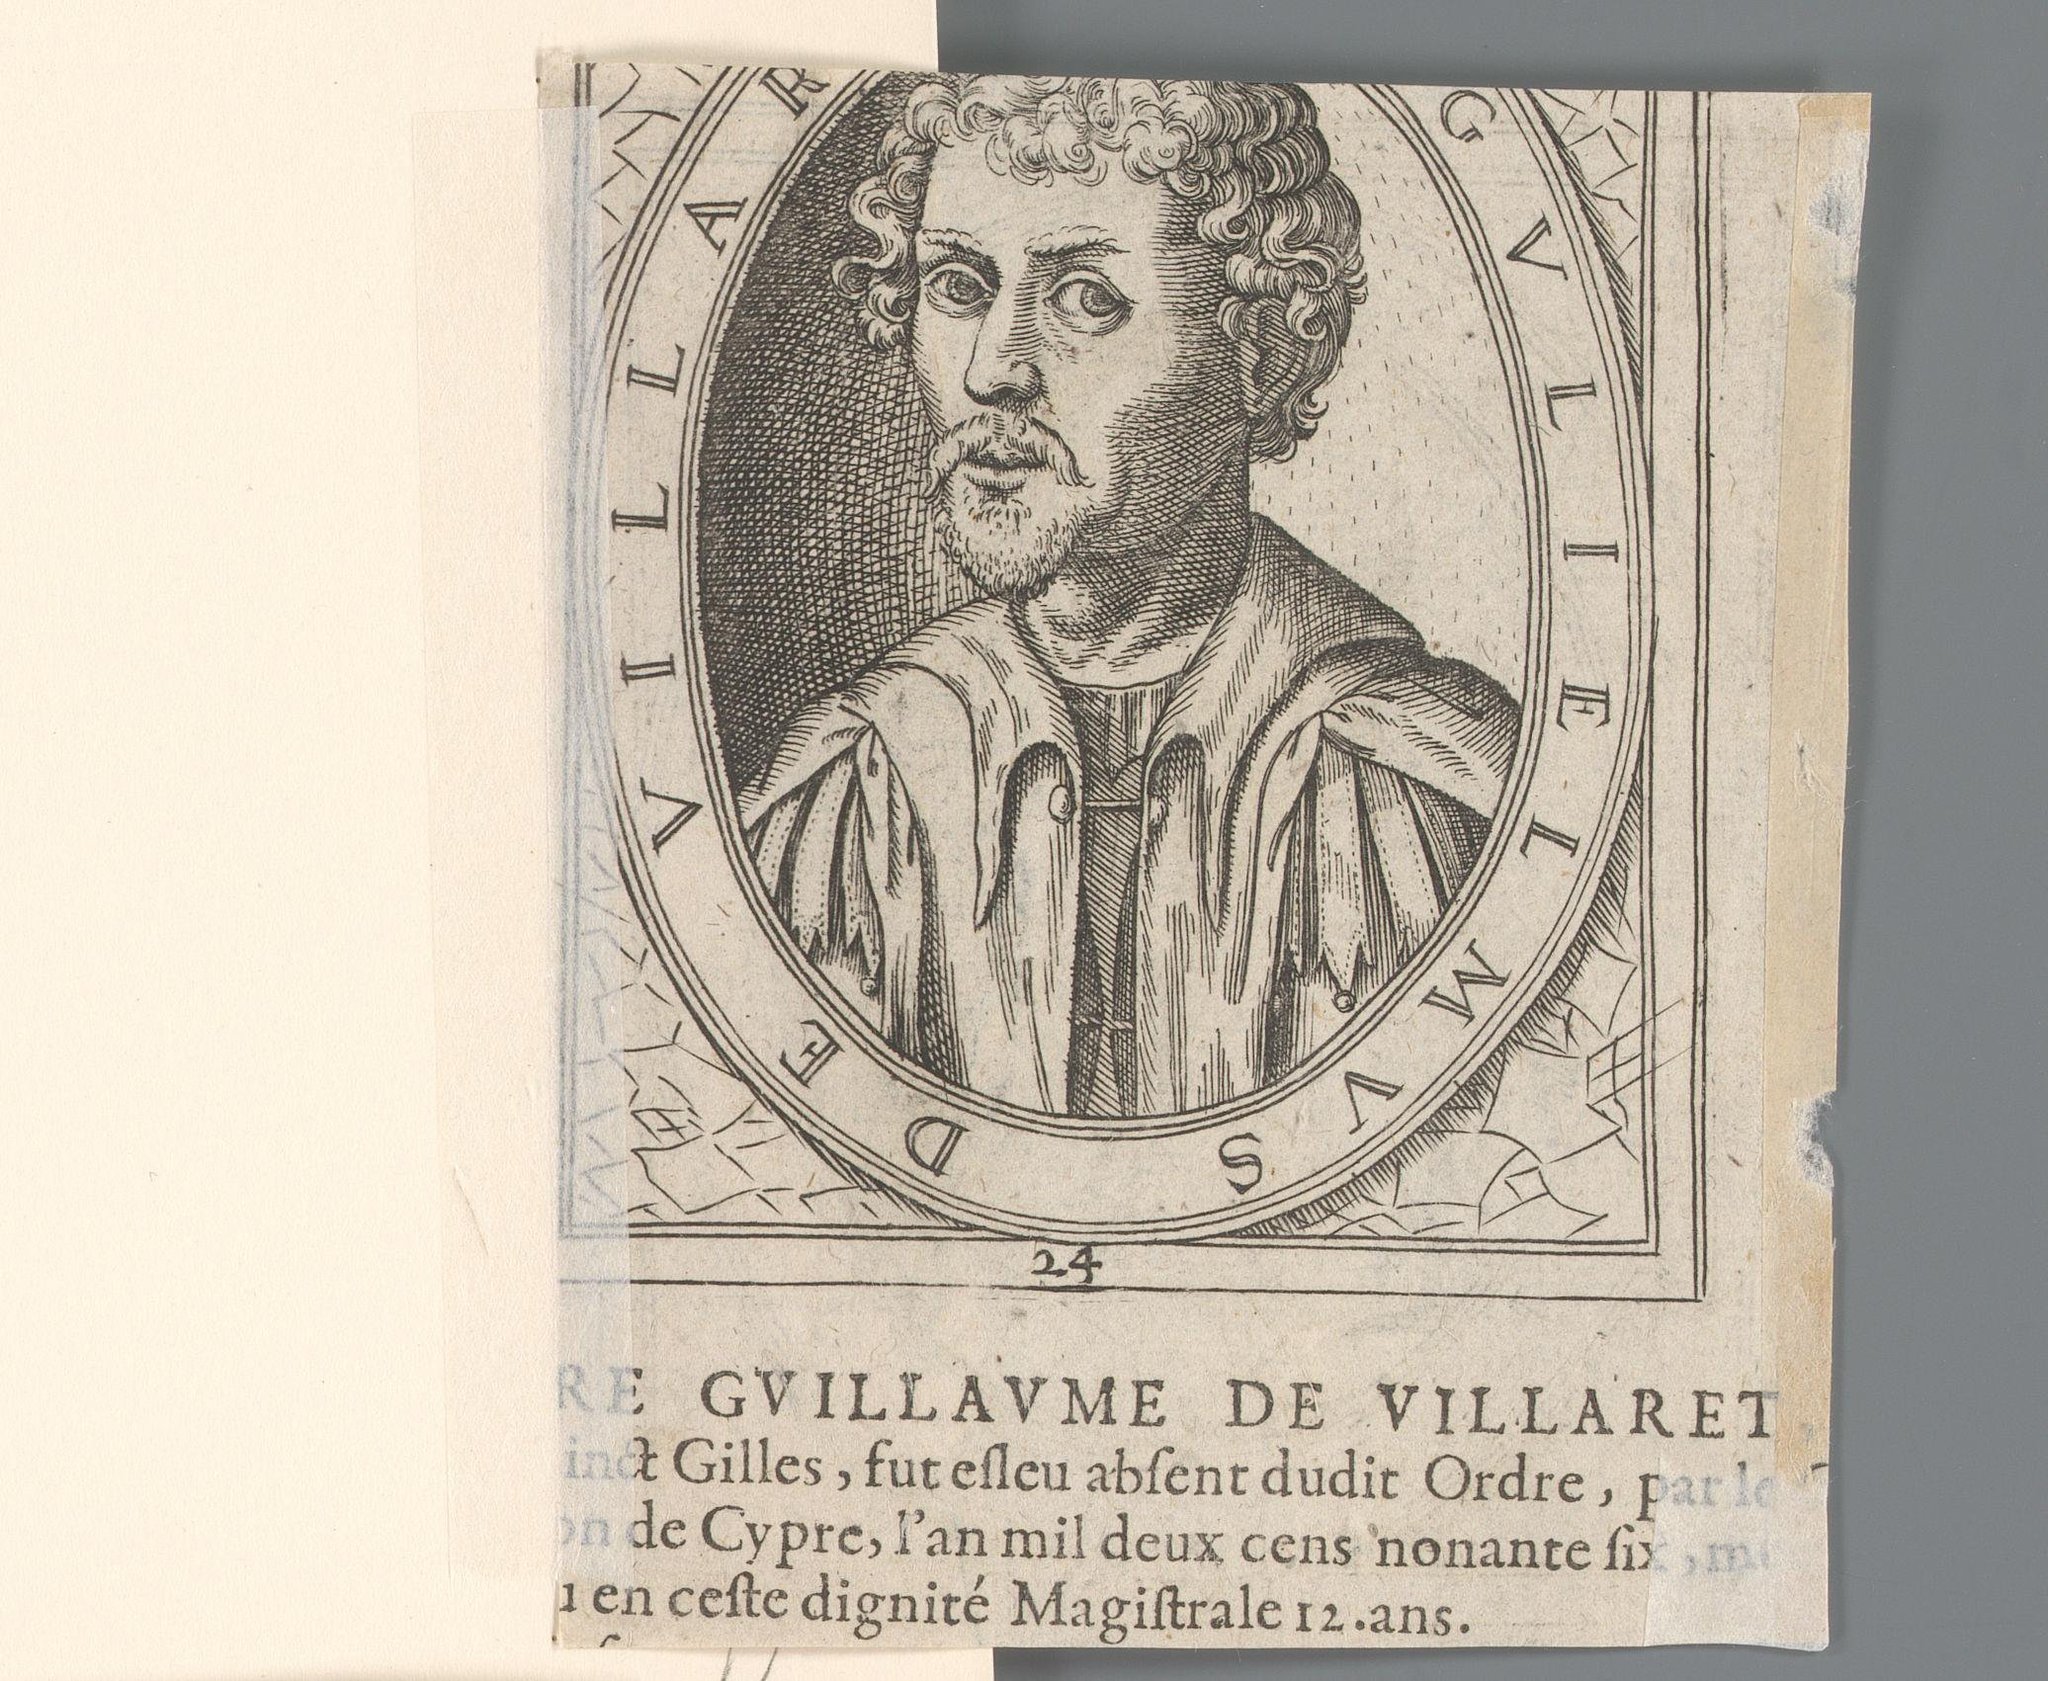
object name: print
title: Portret van Guillaume de Villaret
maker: Anonymous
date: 1643-1659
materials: paper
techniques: engraving, letterpress printing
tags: historical persons, military orders, e.g.: knights templars, knights of malta, teutonic knights ~ roman catholic church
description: Prent mogelijk uit: Baudoin, Jean. Histoire des chevaliers de l'ordre de s. Jean de Hierusalem (...). Parijs: Jacques Dallin, 1643. Of uit: Baudoin, Jean. Histoire des chevaliers de l'ordre de s. Jean de Hierusalem (...). Parijs: Thomas Jolly, 1659.